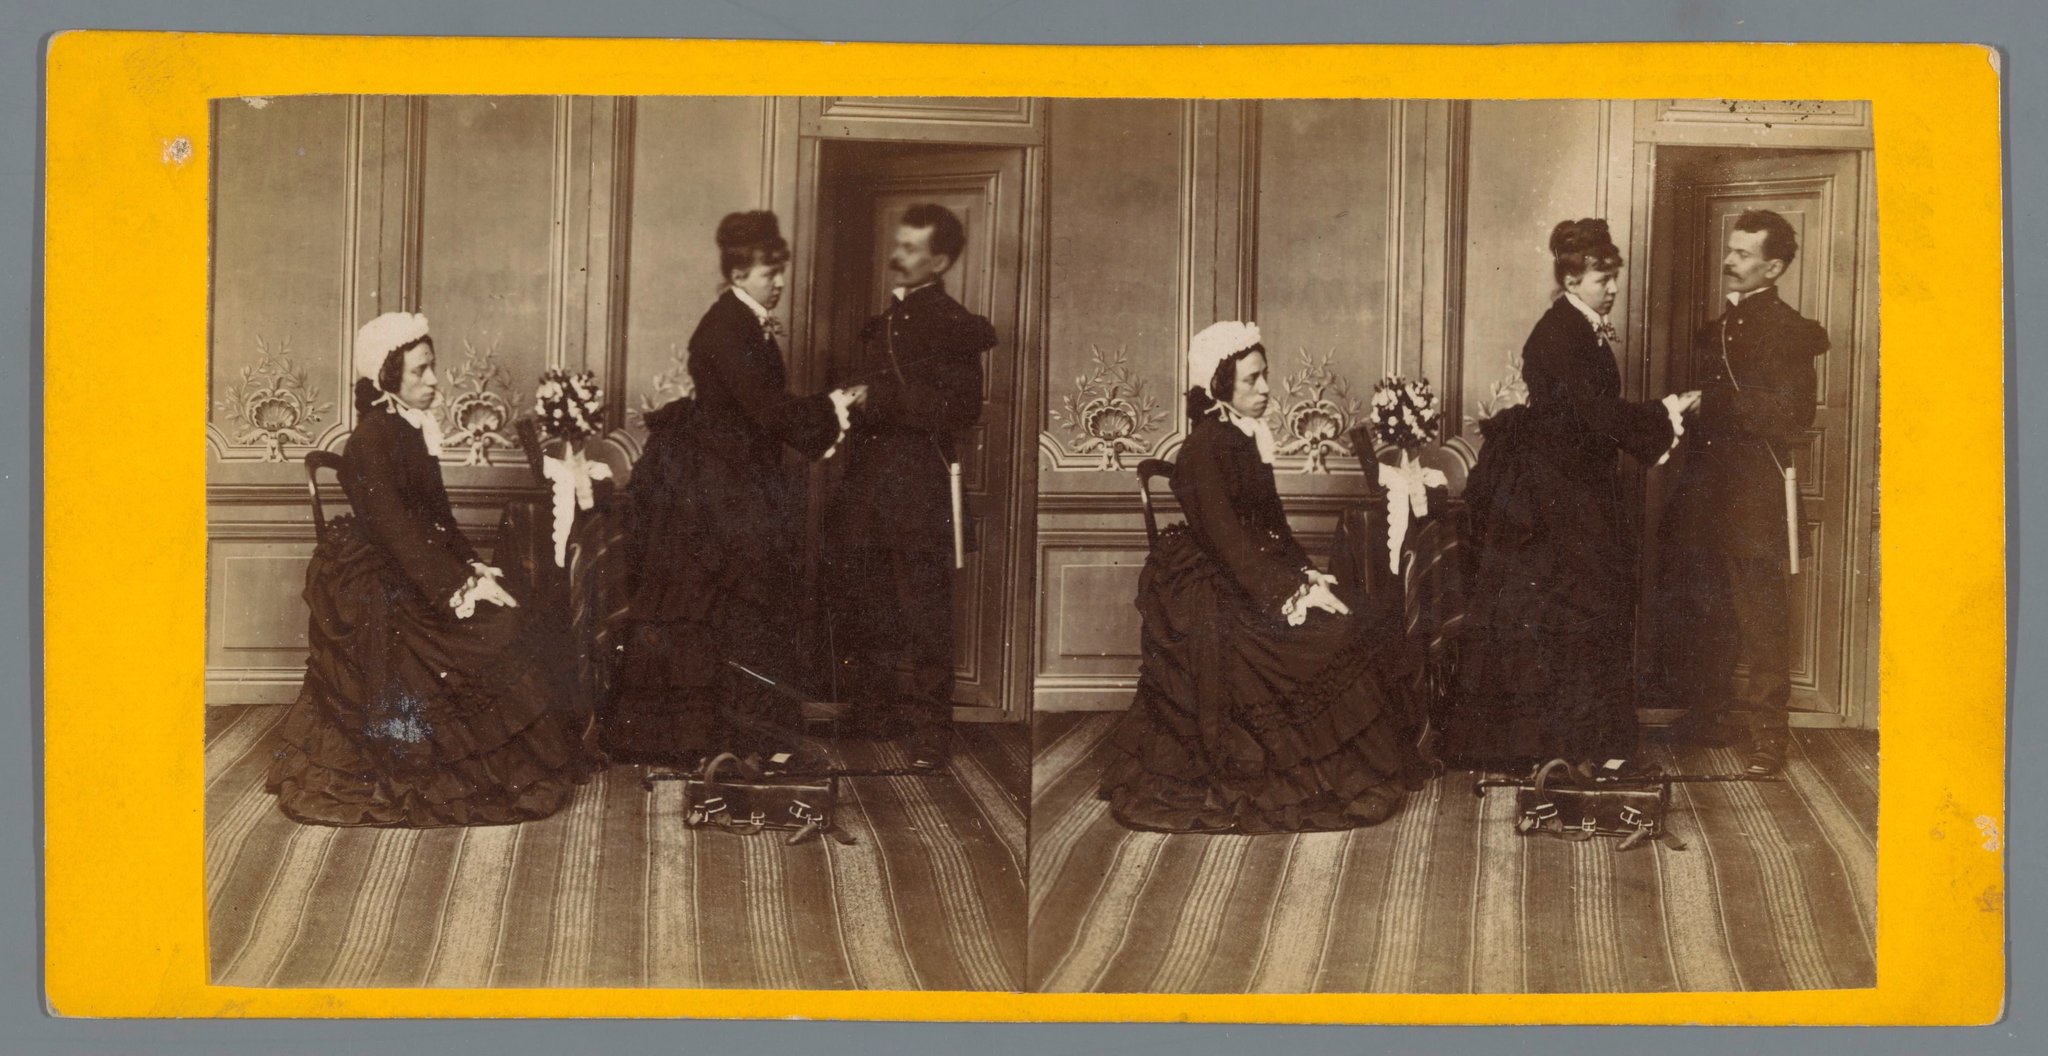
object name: stereograph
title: Vrouw en een man in uniform houden elkaars hand vast, een tweede vrouw kijkt vanaf een stoel toe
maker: Anonymous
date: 1850-1880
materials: cardboard, photographic support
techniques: albumen print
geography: europe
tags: europe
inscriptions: number: ‘121 k’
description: Voor de personen ligt een tas met wandelstok op de grond.